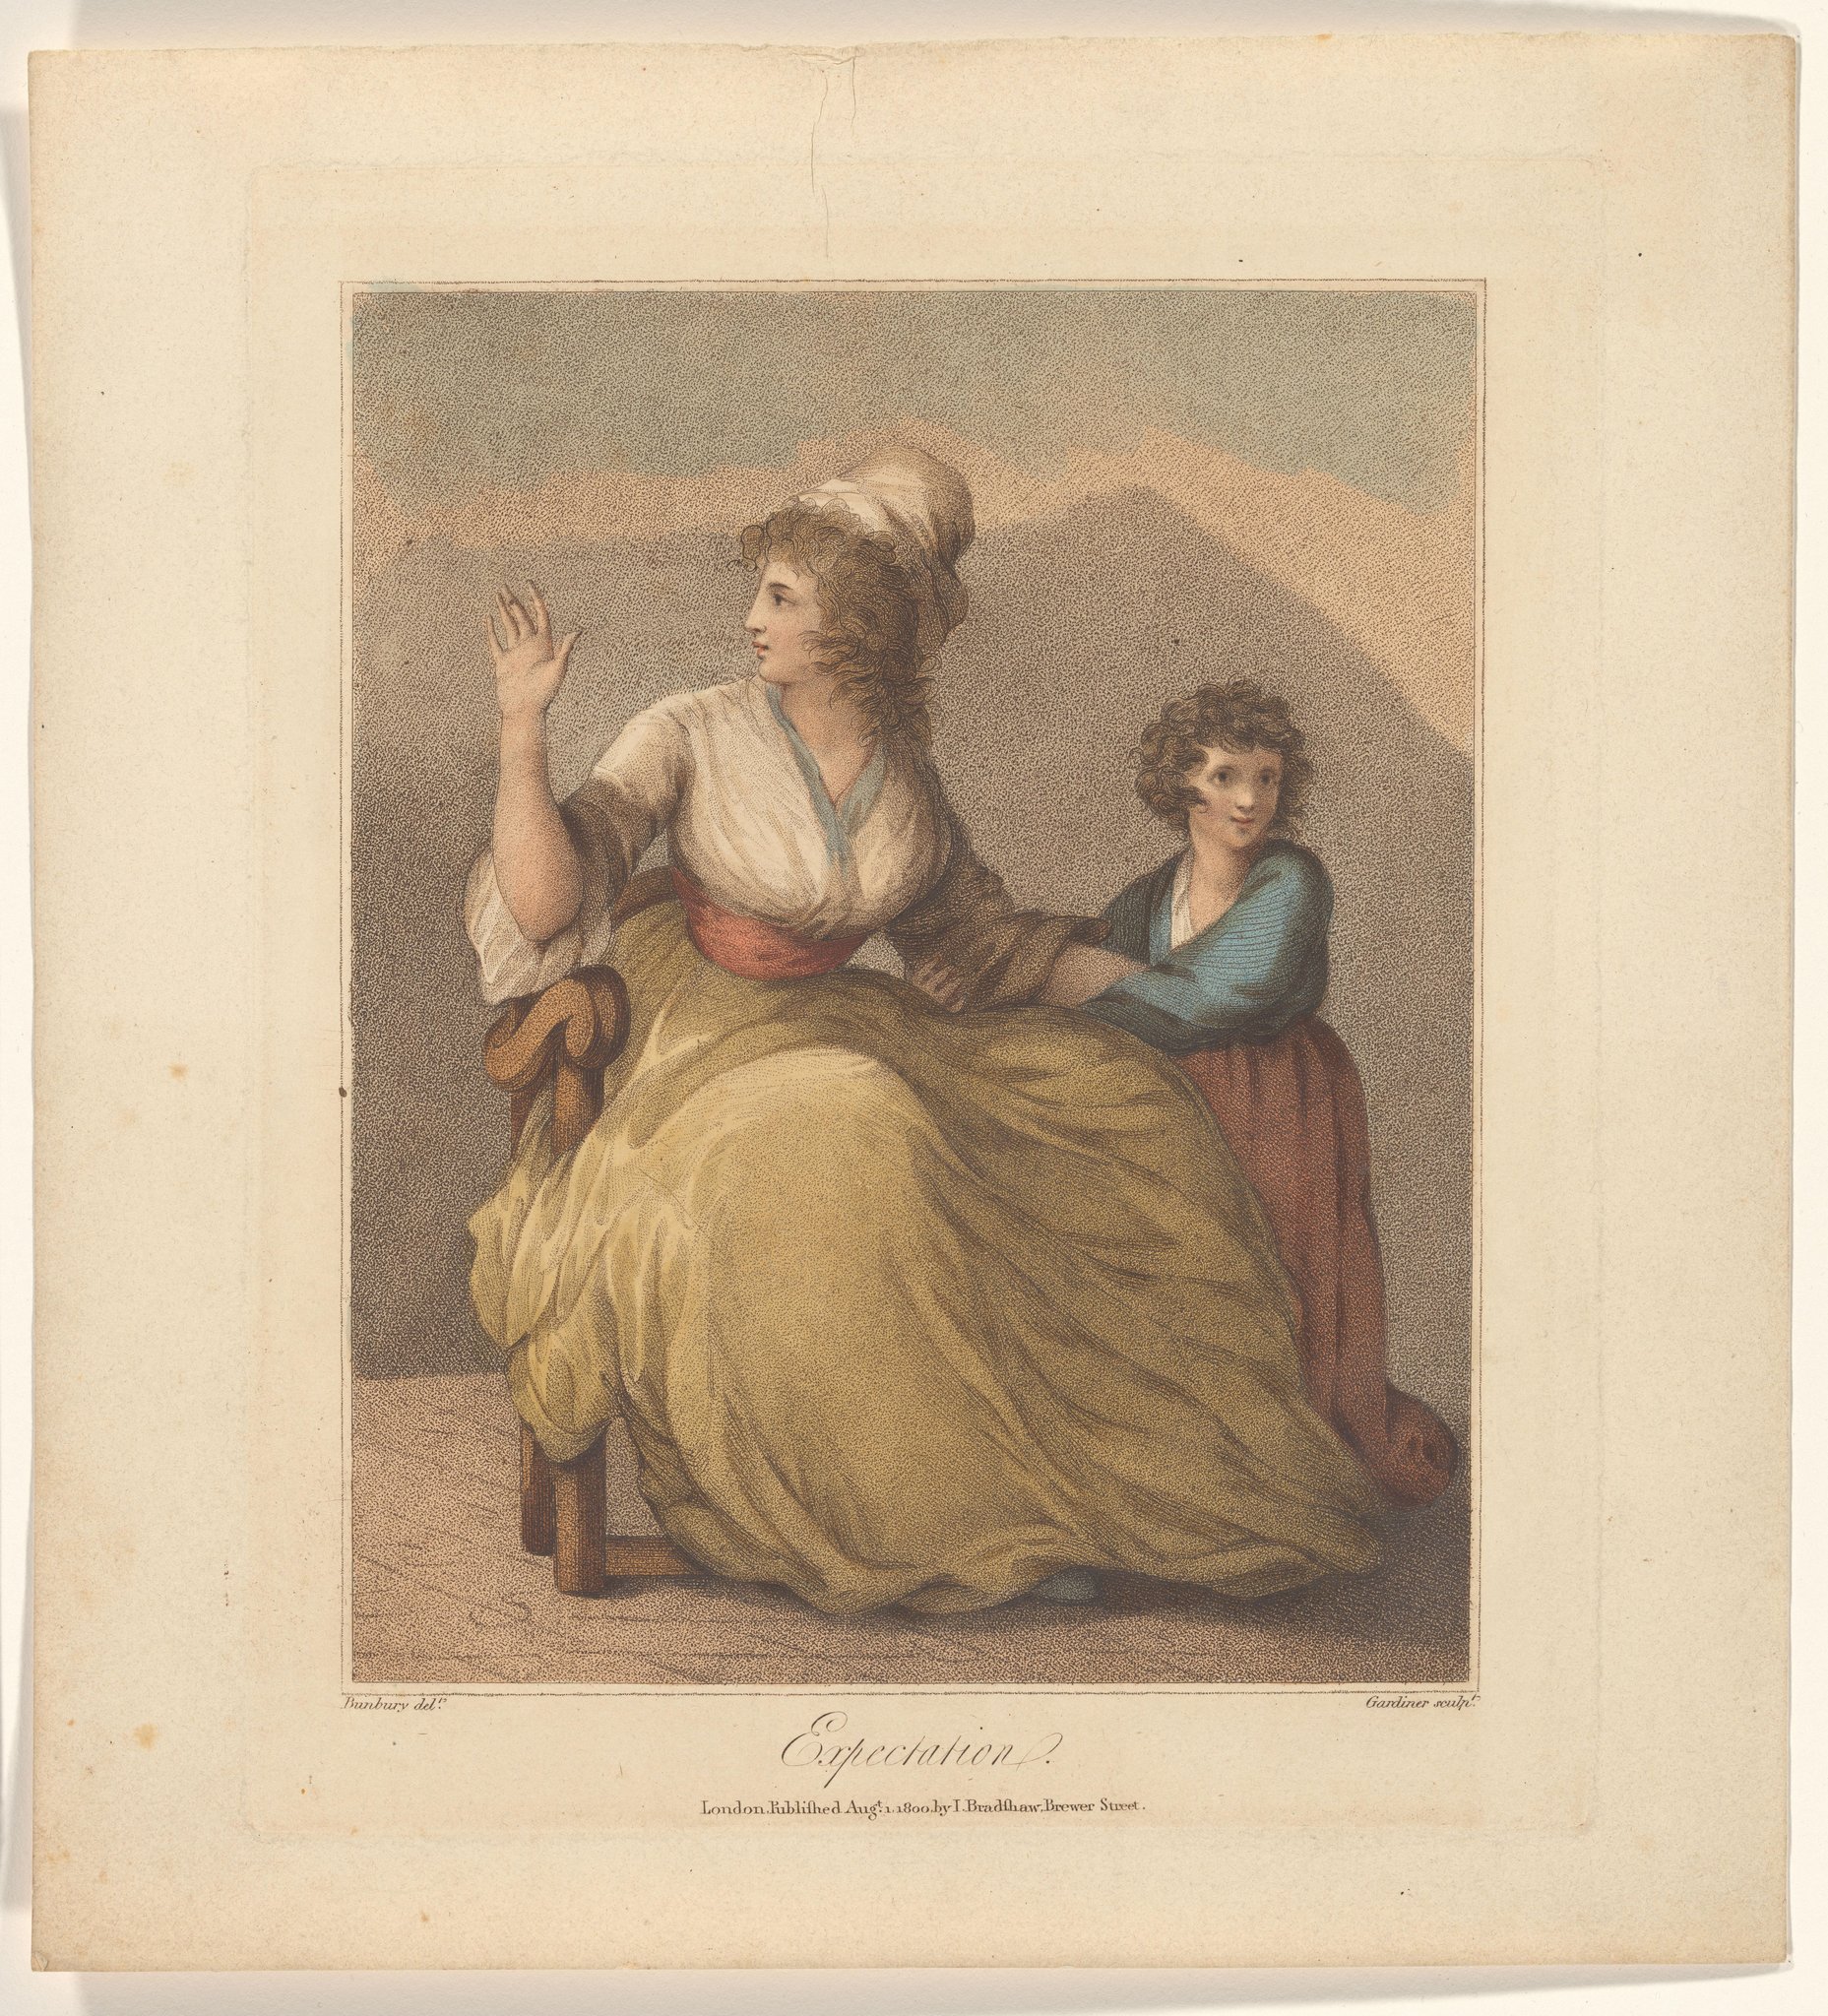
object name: print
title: Verwachting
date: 1800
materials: paper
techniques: hand coloring, engraving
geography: london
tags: family group, especially parents with their child(ren), expectation, mother and baby or young child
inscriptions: collector's mark: Lugt 2228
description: Zittend in een berglandschap steekt een vrouw haar hand op en kijkt naar links, alsof ze een langverwachte komst verwacht. Een kind dat achter haar staat, kijkt de kijker aan.